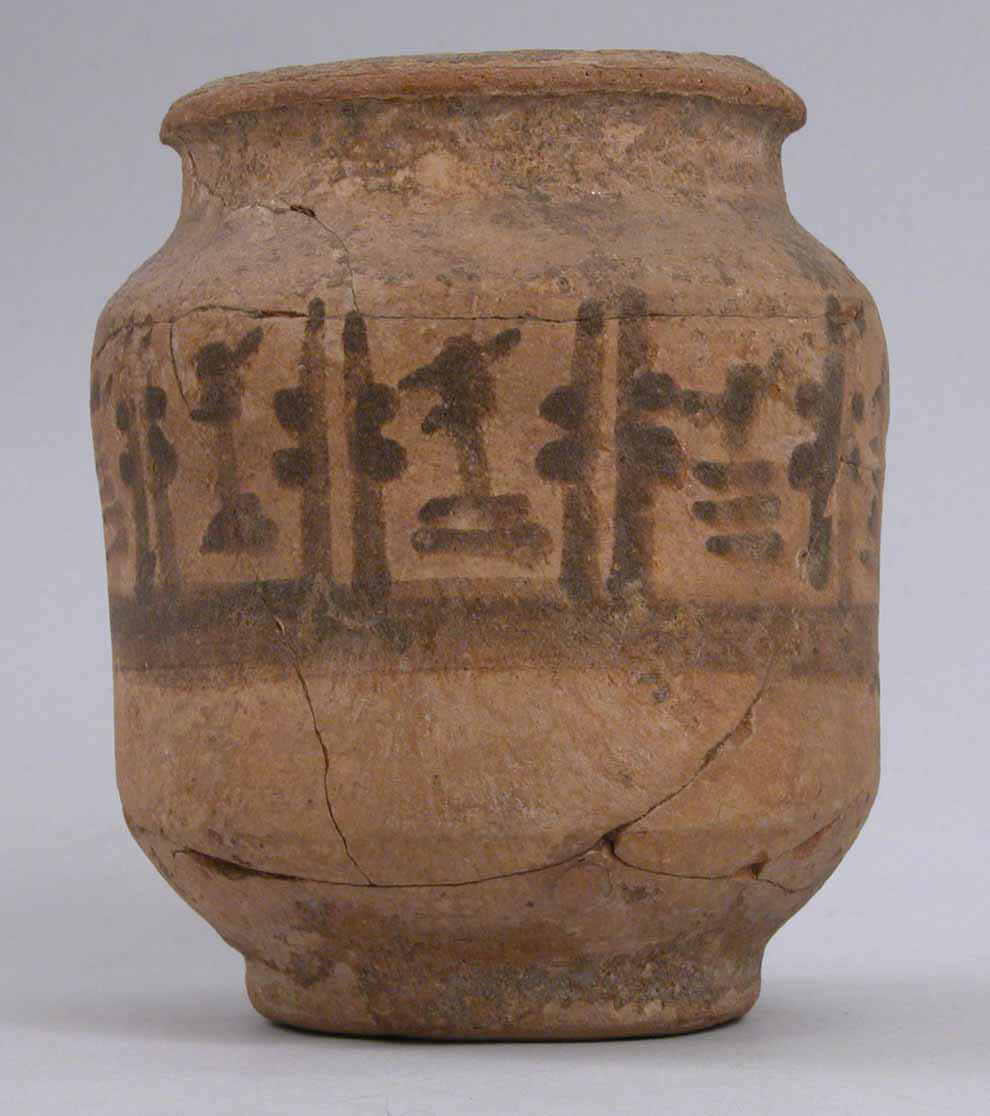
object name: jar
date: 801-1000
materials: earthenware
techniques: painting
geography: iran